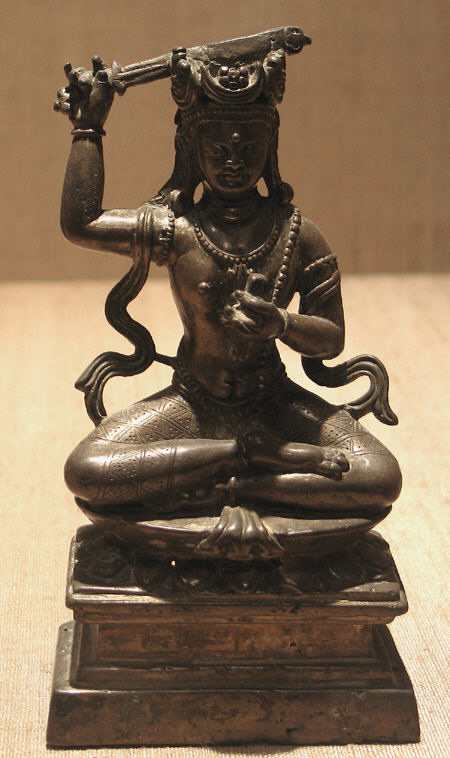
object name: figure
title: Manjushri, the Bodhisattva of Transcendent Wisdom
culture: india, himachal pradesh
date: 901-1000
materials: brass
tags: swords,buddhism,bodhisattvas,manjushri